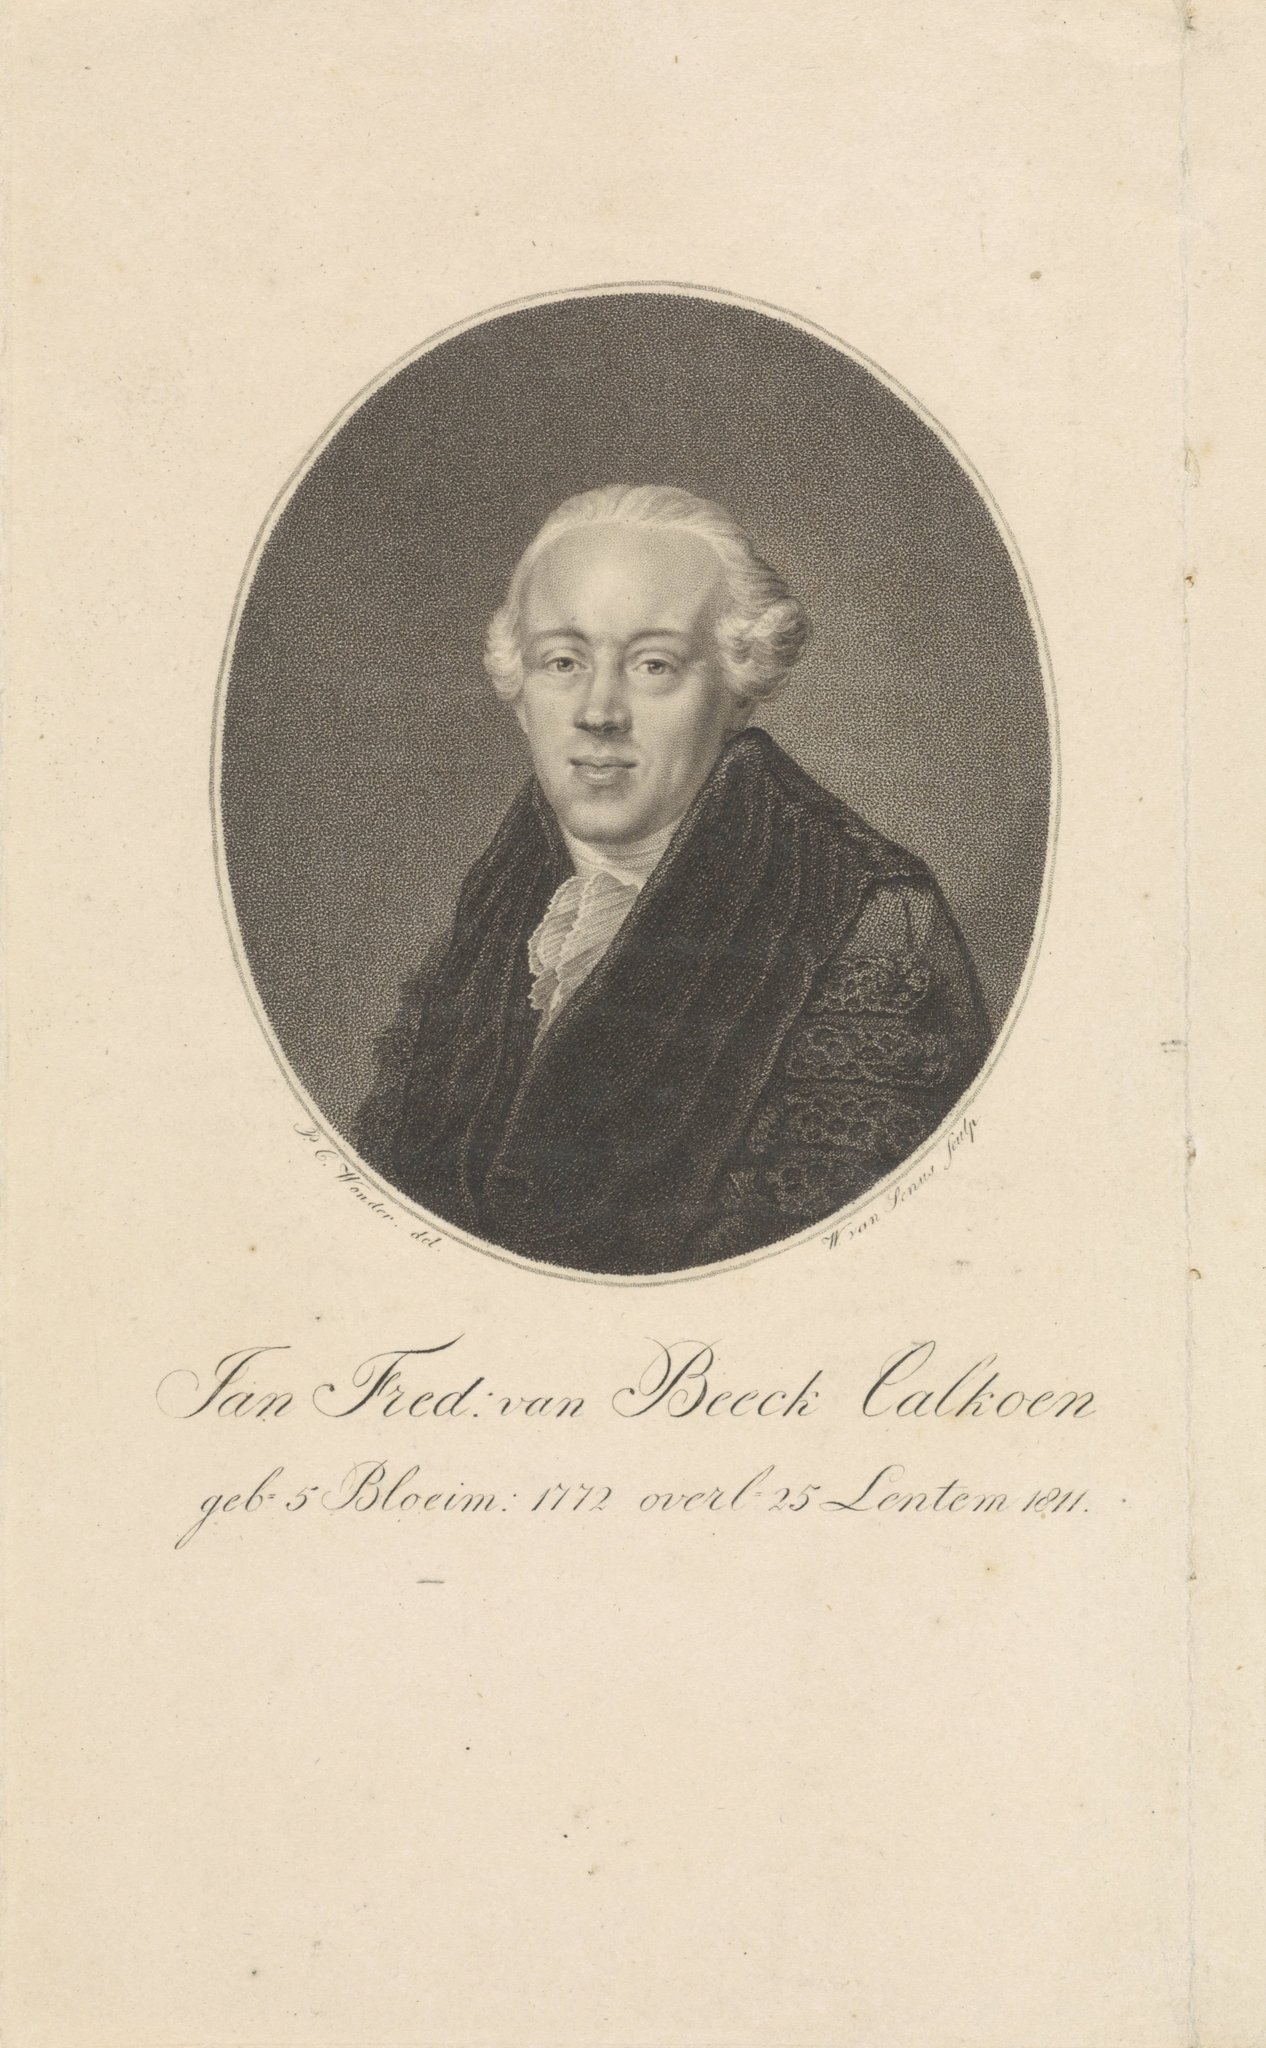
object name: print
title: Portret van Jan Frederik van Beeck Calkoen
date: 1811-1851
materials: paper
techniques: engraving, etching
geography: netherlands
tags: utrecht, physicist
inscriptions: collector's mark: Lugt 2228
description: Portret van Jan Frederik van Beeck Calkoen, filosoof, natuurkundige en hoogleraar in de wiskunde te Leiden en Utrecht.